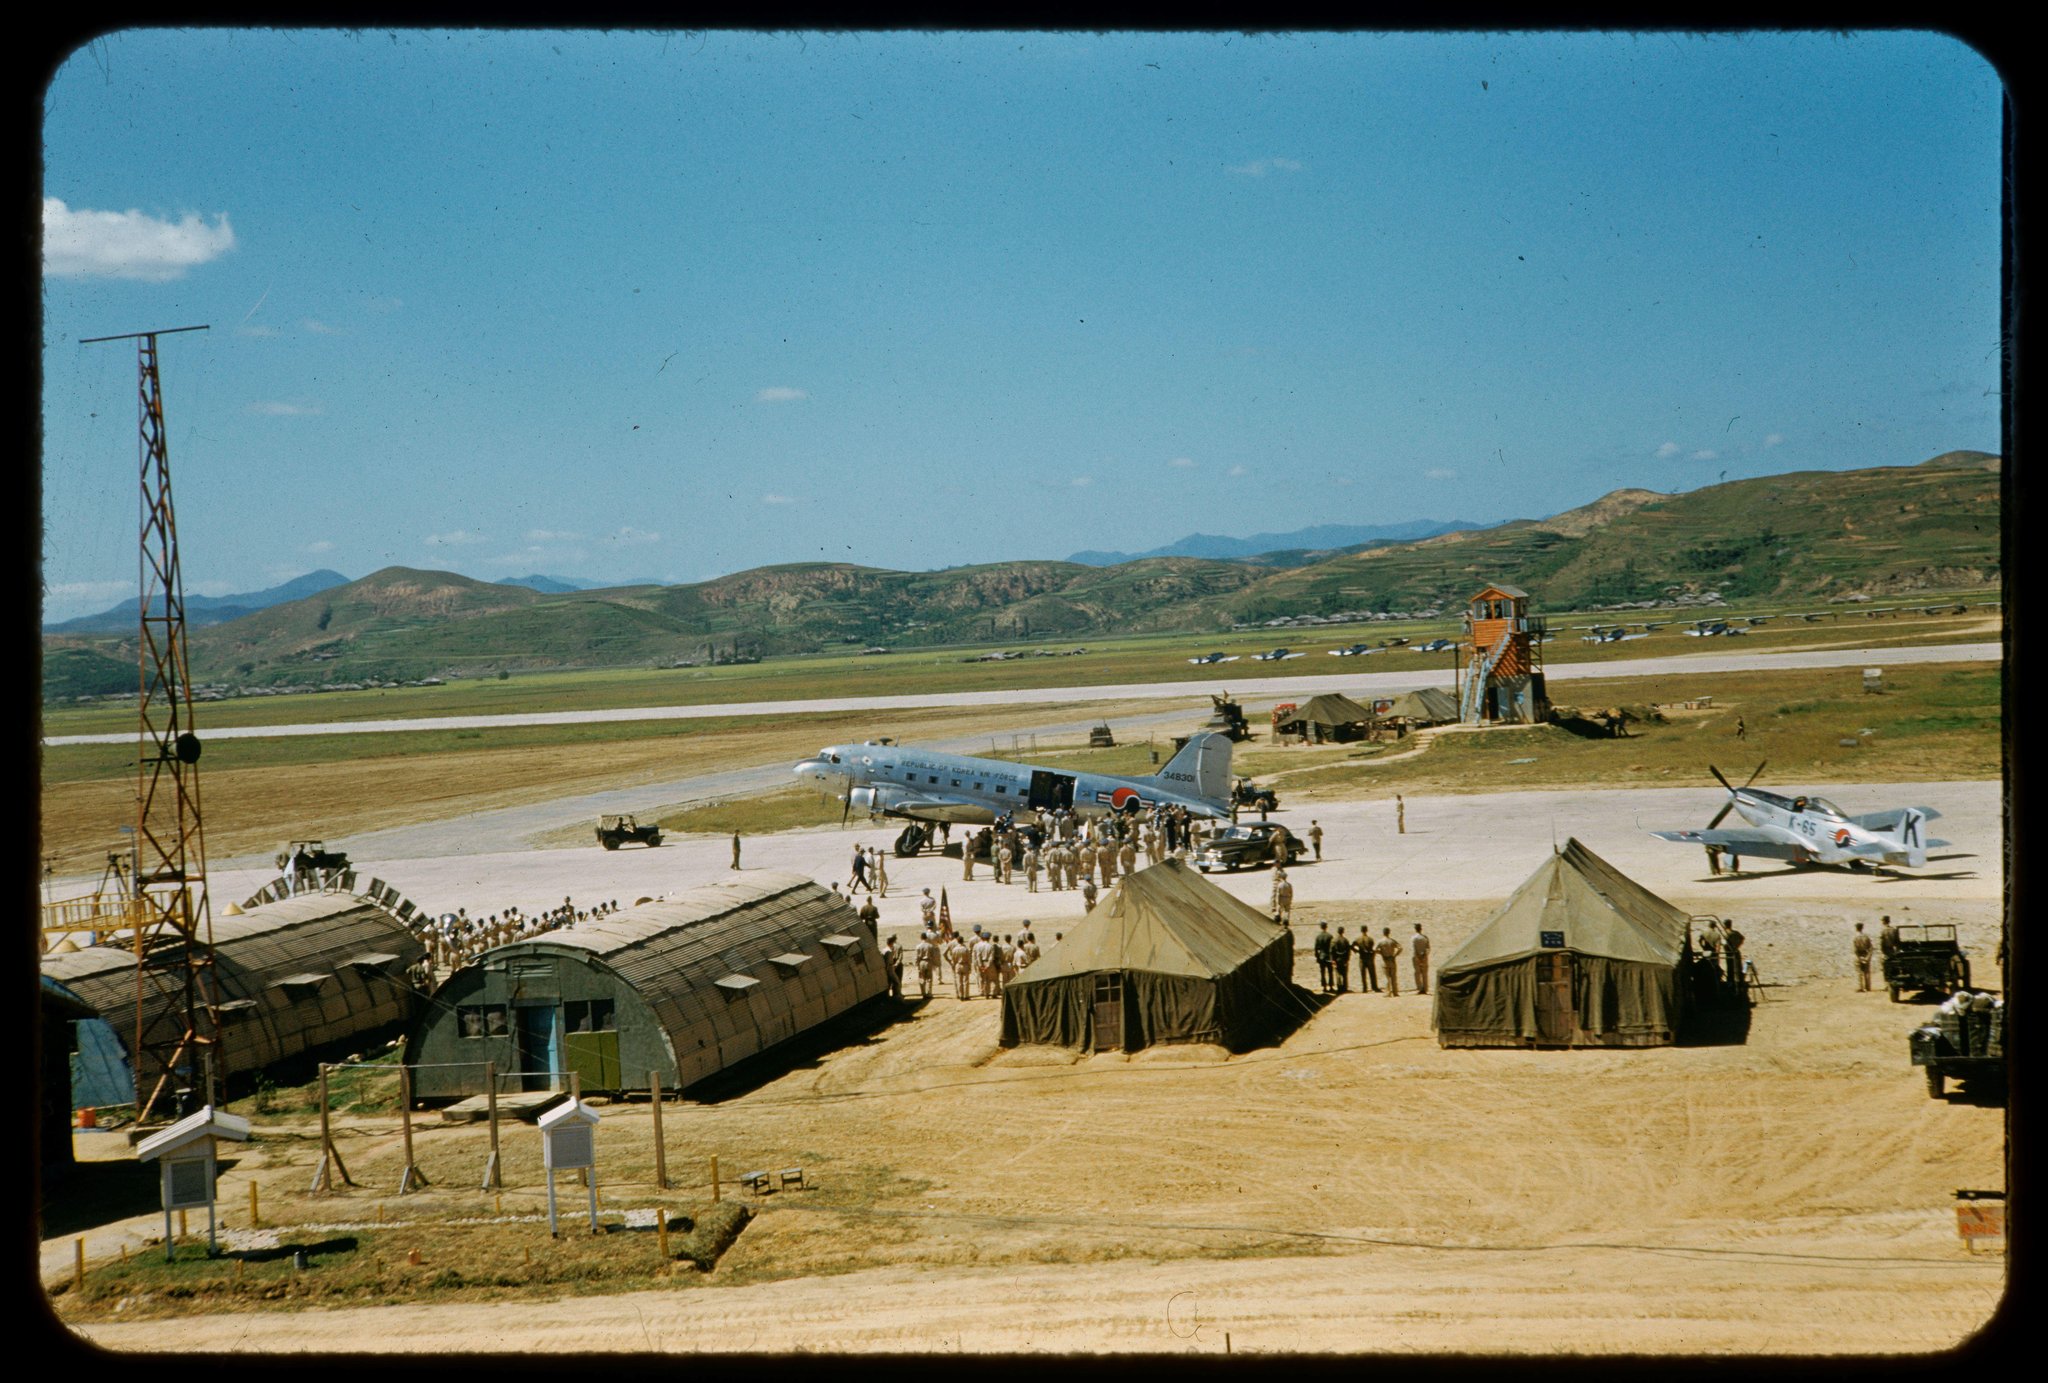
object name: color slide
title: Oorlog in Korea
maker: david ketel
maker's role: diplomaat, sinoloog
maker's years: 1913-2008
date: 1909-1952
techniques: slide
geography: korea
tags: united nations